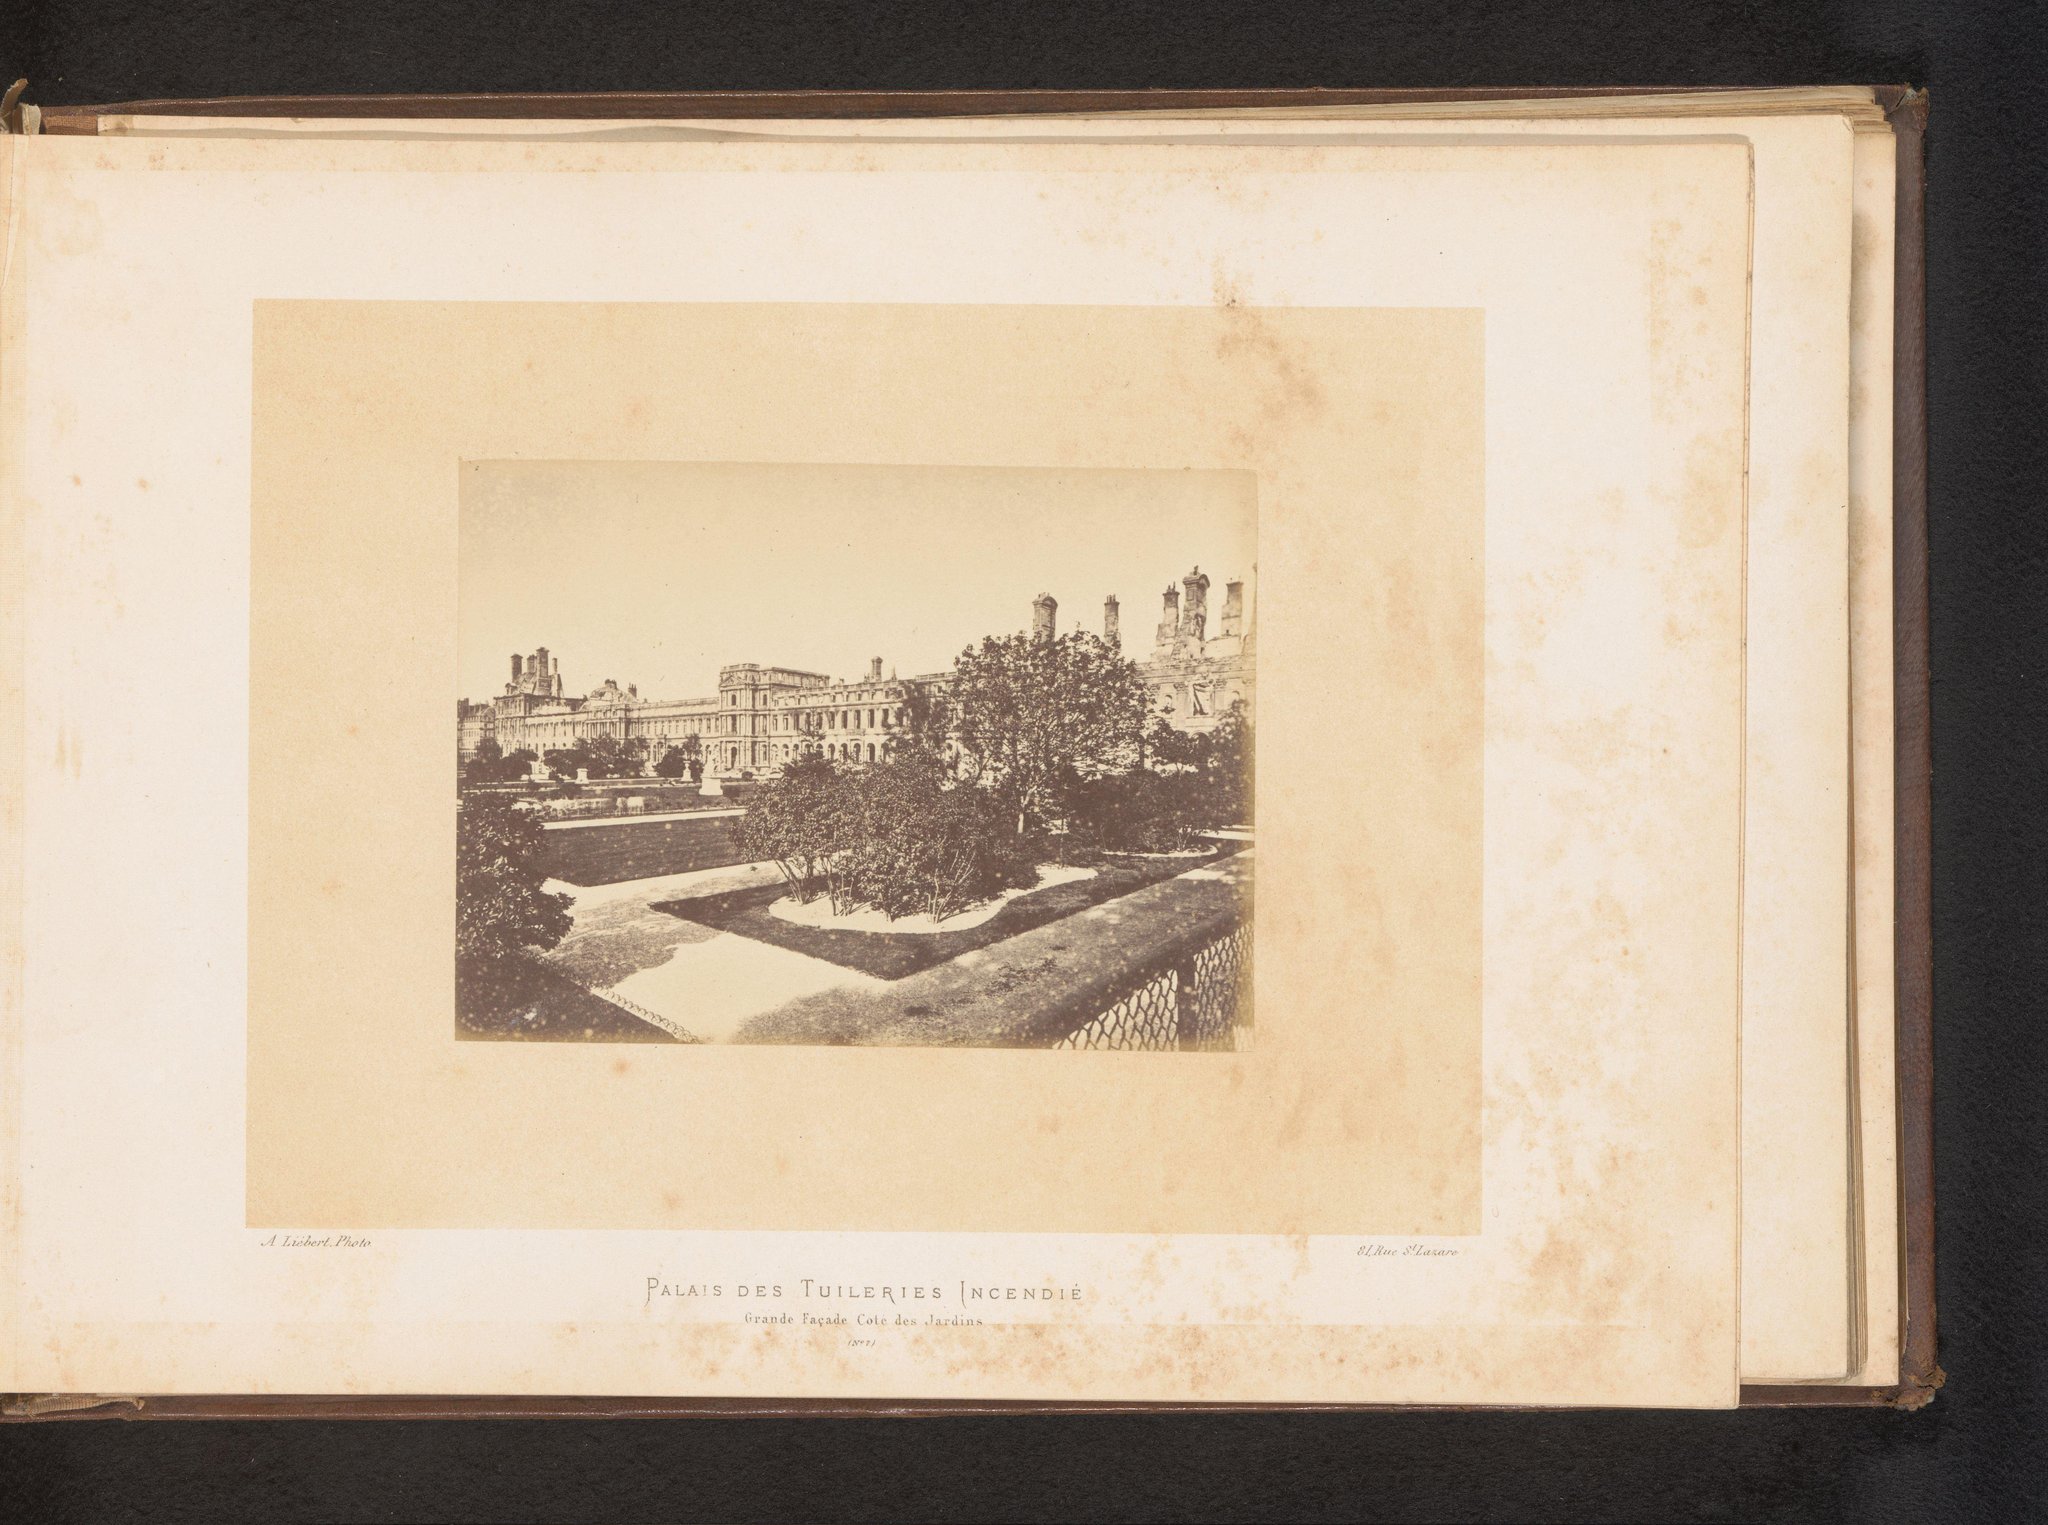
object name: photograph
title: Palais des Tuileries Incendié. Grande Façade Coté des Jardins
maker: alphonse-justin liébert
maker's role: fotograaf, marinier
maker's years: 1827-1914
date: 1871-1872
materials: photographic support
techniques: albumen print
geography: paris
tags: ruin of a building ~ architecture, palace, tuileries palace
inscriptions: number: ‘(No. 7)’, address: ‘31, Rue St. Lazare’